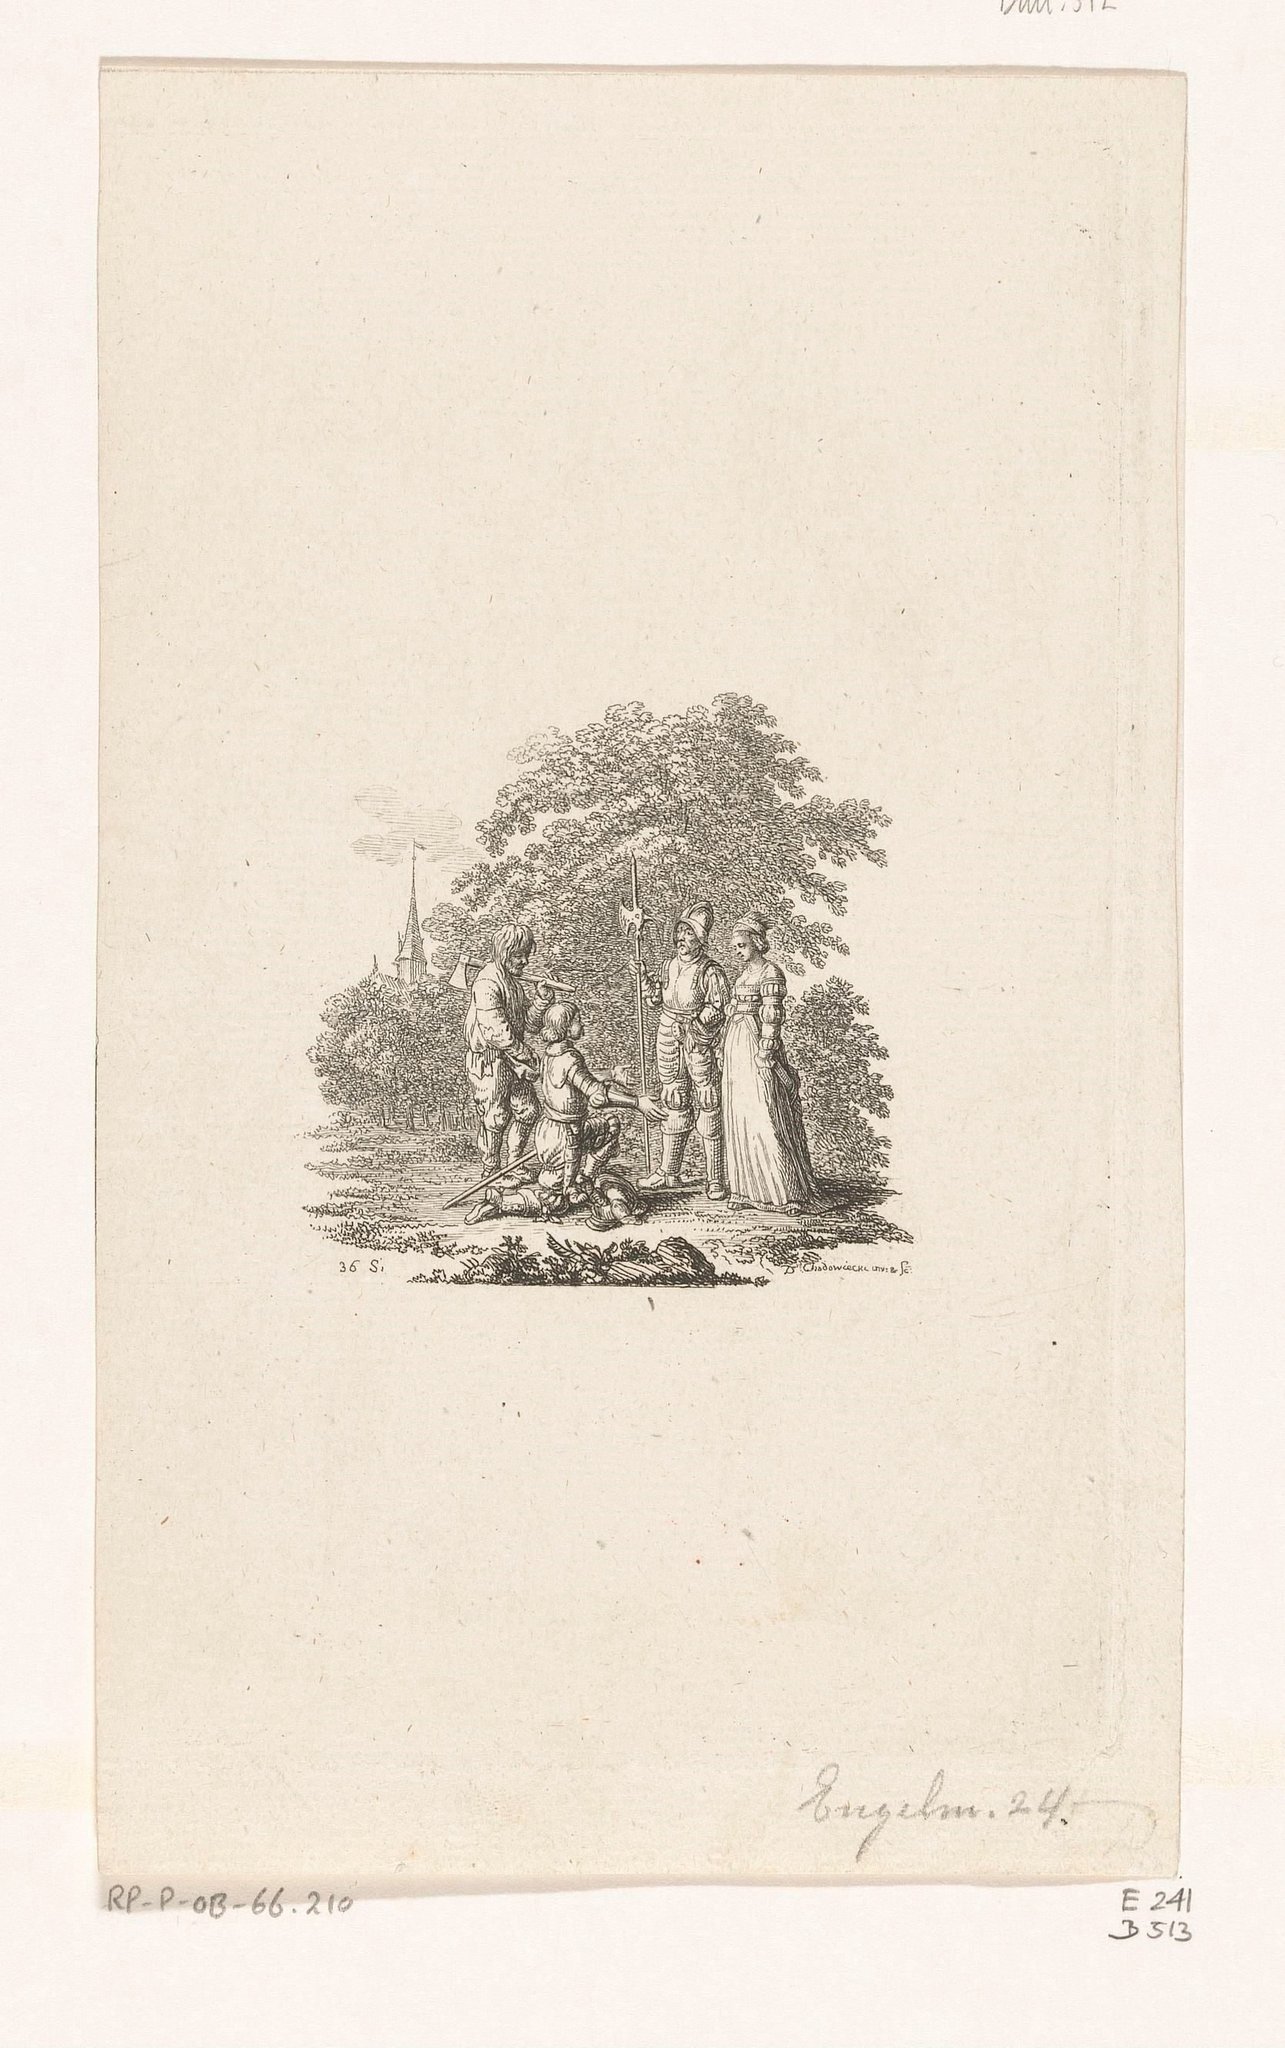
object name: print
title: Huwelijksaanzoek van Robert von Hohenecken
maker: daniel nikolaus chodowiecki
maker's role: draughtsman, print maker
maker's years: 1726-1801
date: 1778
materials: paper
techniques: etching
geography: berlin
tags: official, proposal, declaration of love, knight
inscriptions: collector's mark: Lugt 240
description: Deze prent werd op een plaat geëtst met een scène gebaseerd op een werk van Henry Mackenzie (zie: RP-P-OB-13.978). Deze prent is ook gebruikt in: Hahn, Ludwig Philipp. Robert von Hohenecken. Ein Trauerspiel. Leipzig: Weygandschen Buchhandlung, 1778.